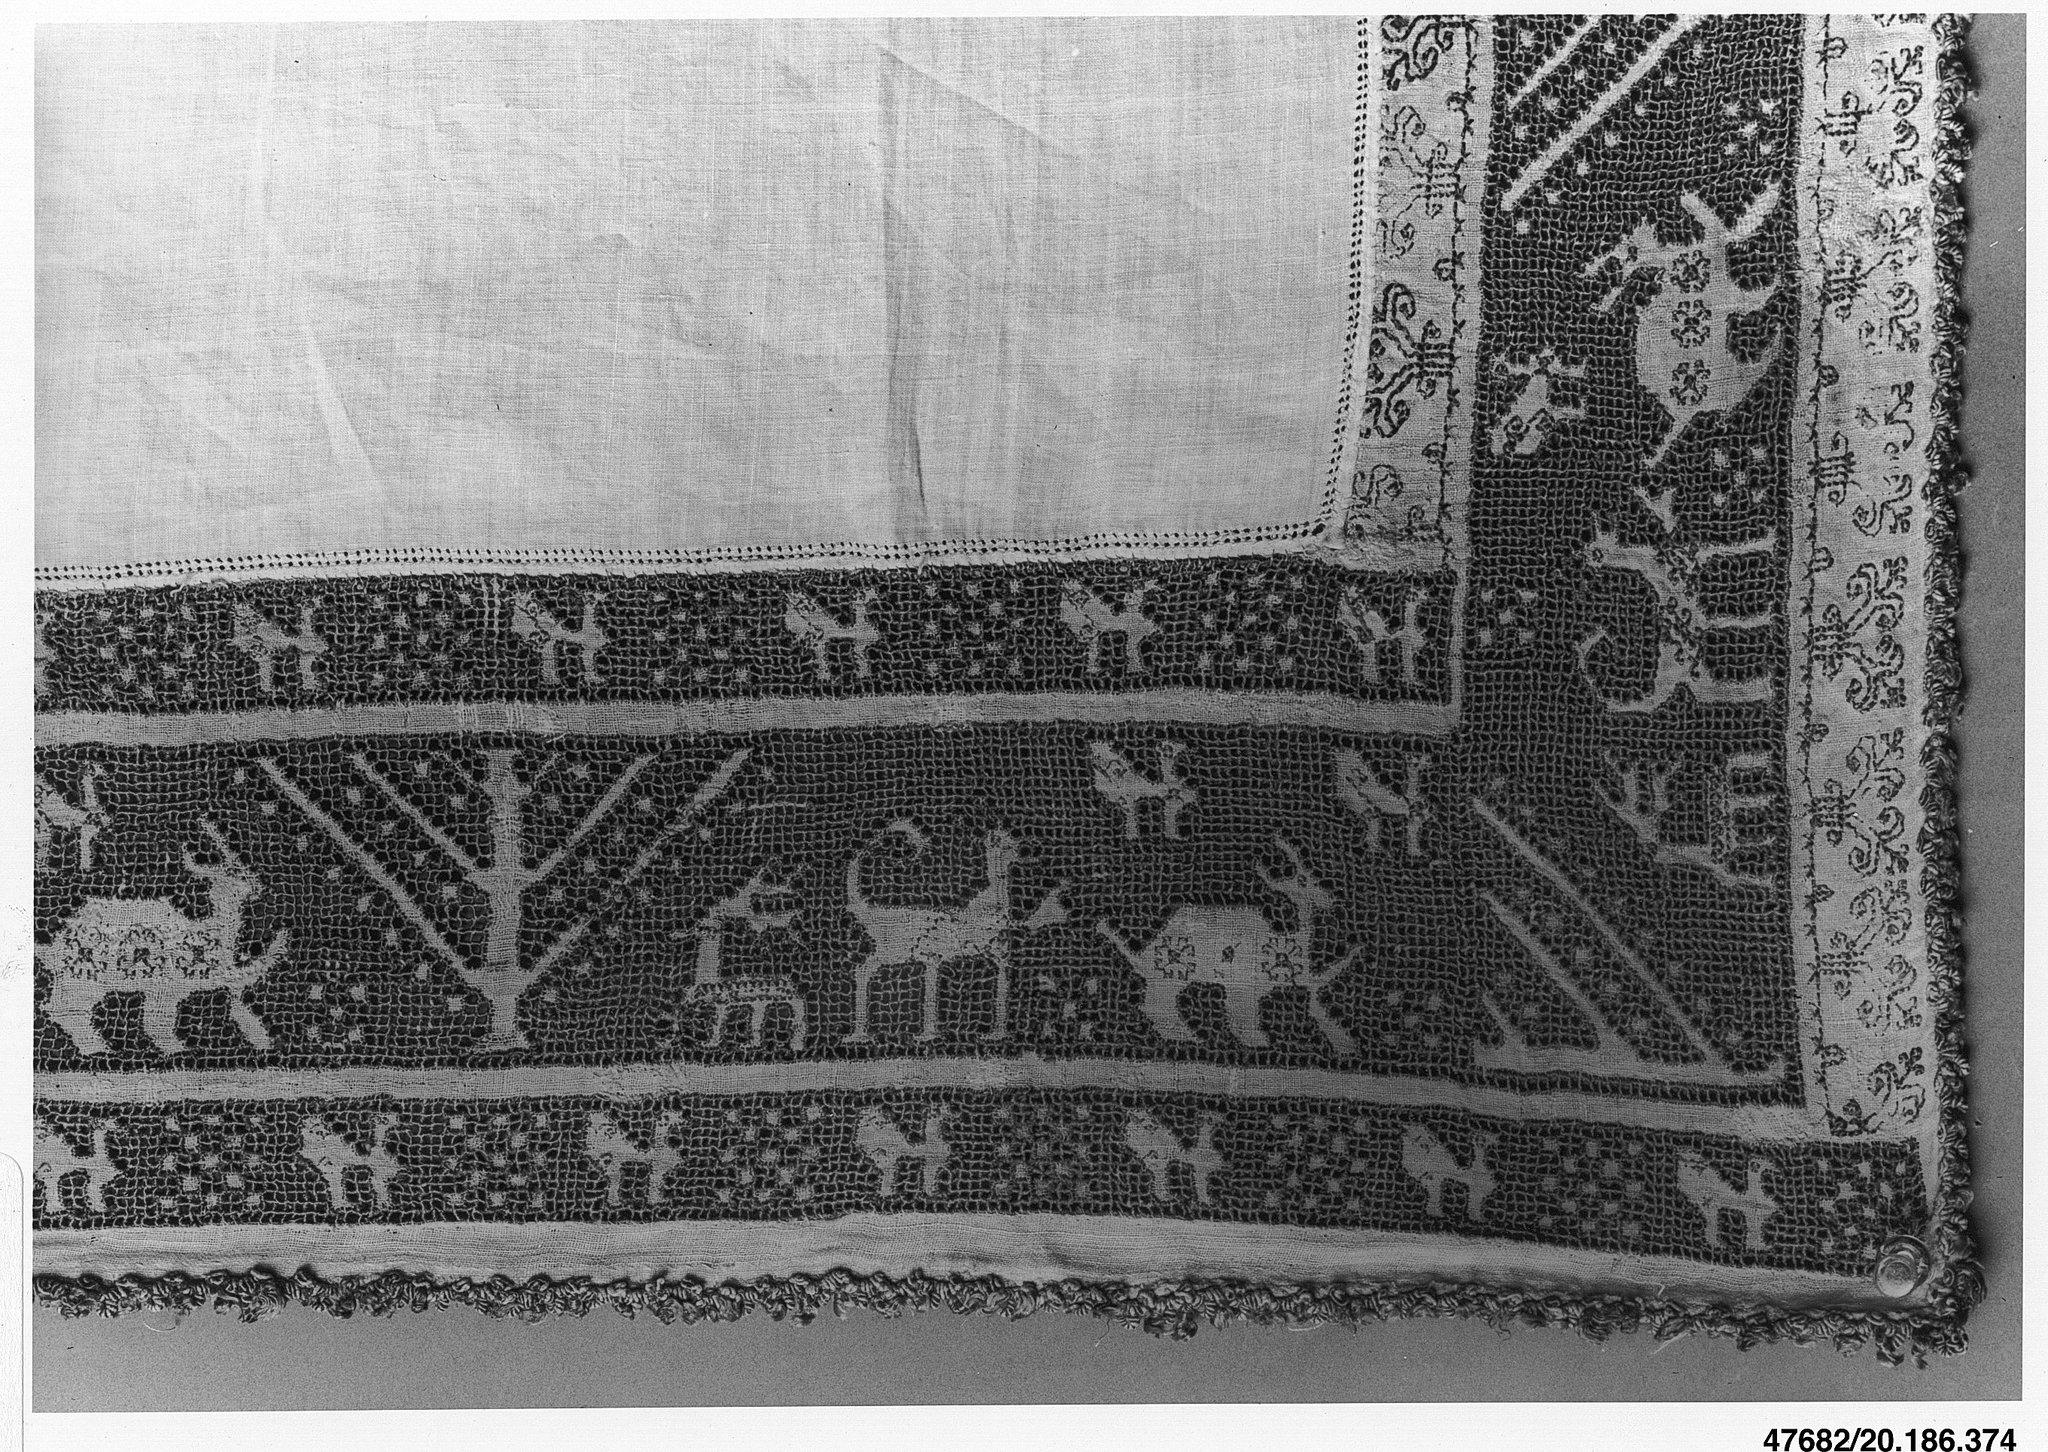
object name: altar cloth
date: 1401-1500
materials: linen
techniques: lace, embroidery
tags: animals